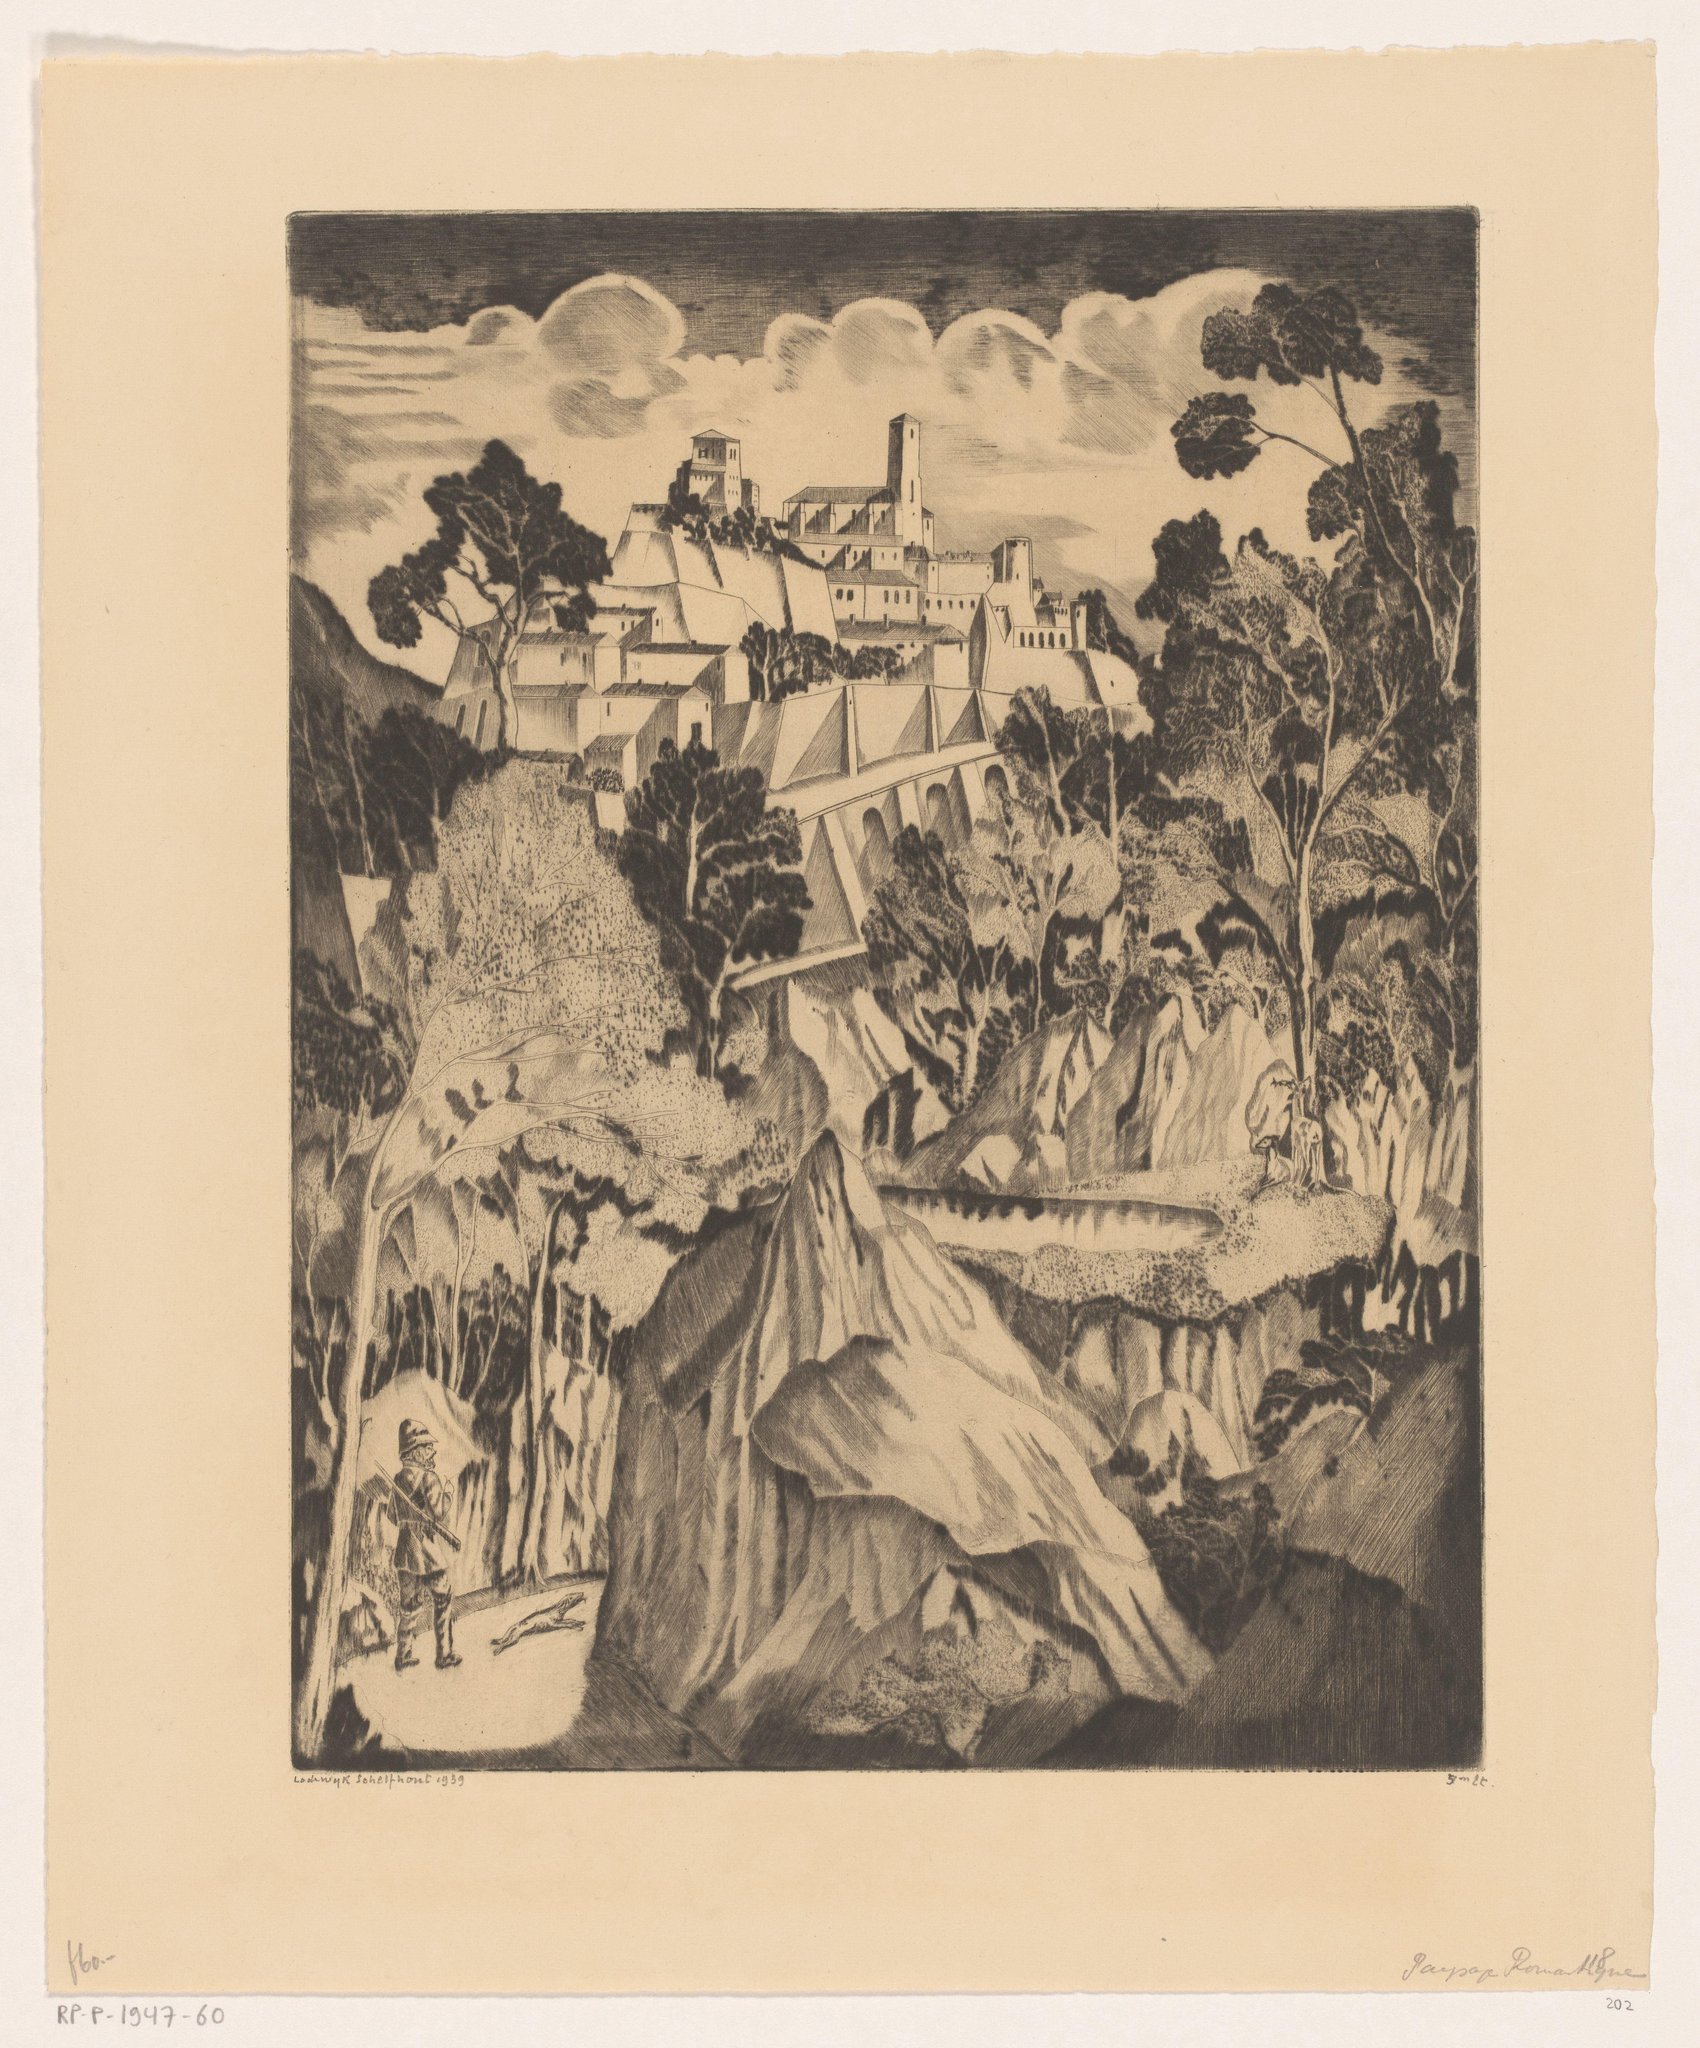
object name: print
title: Heuvellandschap met jager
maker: lodewijk schelfhout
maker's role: draughtsman, print maker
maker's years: 1881-1943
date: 1939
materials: paper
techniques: drypoint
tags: trees, hunter, (high) hill - hh - ideal landscapes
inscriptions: collector's mark: Lugt 2228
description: Een met bomen begroeid heuvellandschap met een nederzetting. Links op de voorgrond een jager die een geweer om zijn schouder draagt en een liggende hond. In het midden een meer waarbij zich twee herten bevinden.